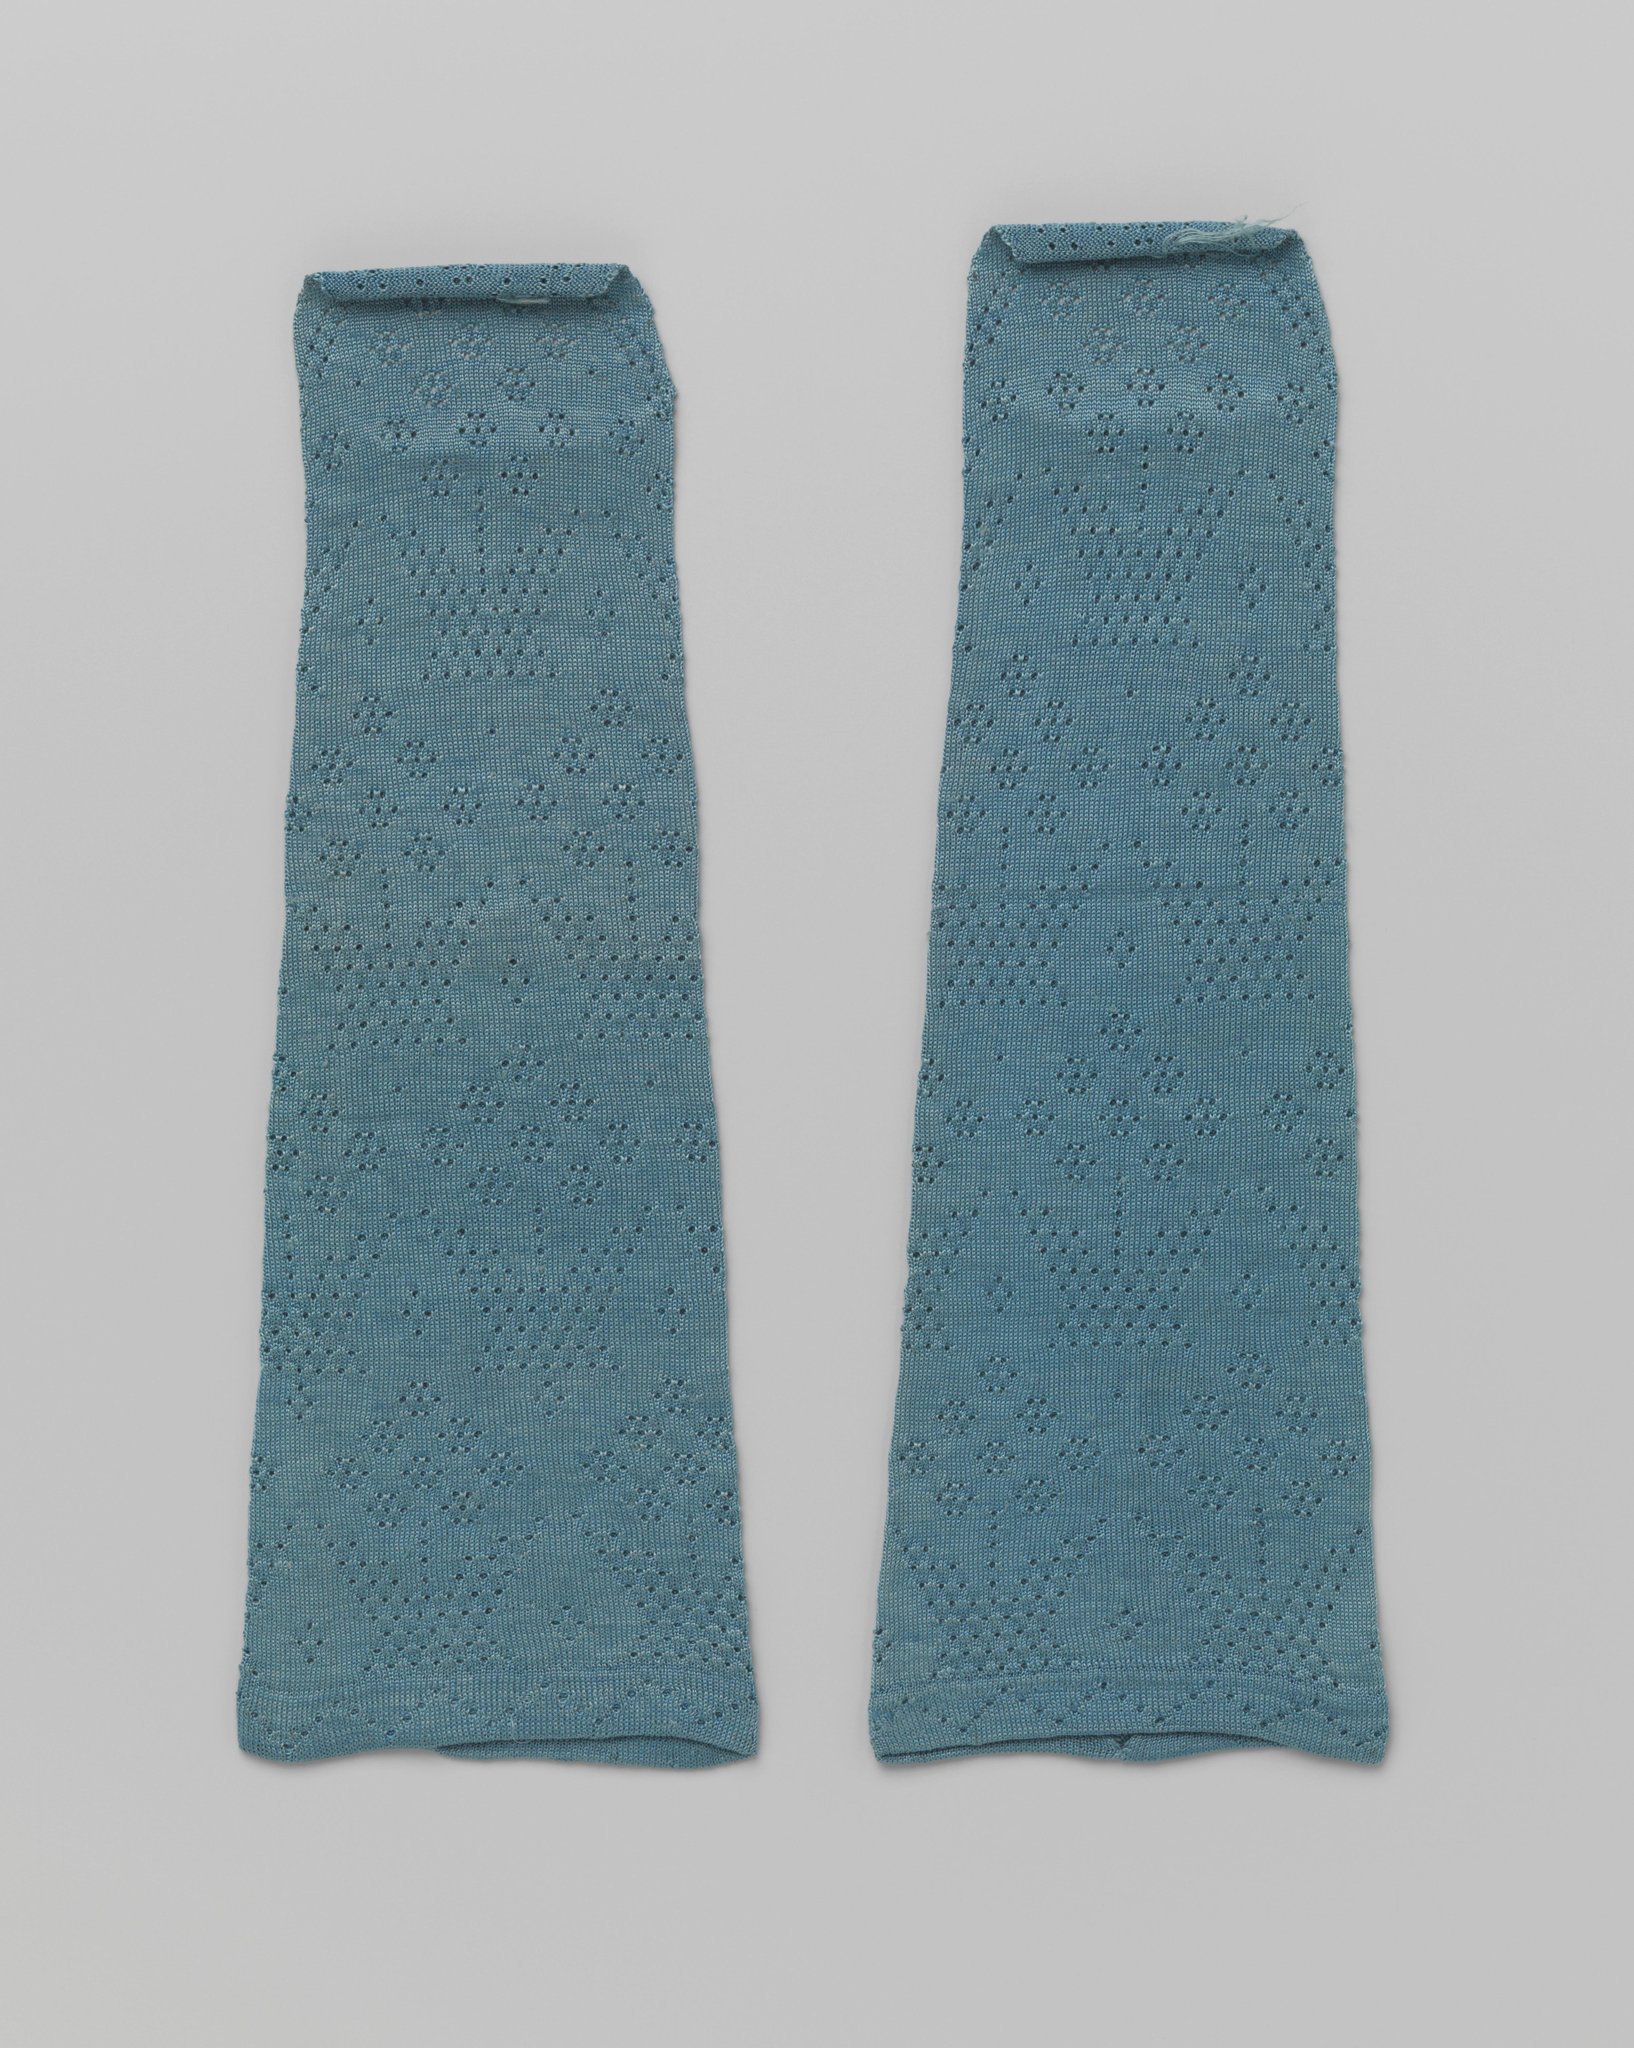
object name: clothing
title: Mitaine van blauwe zijde, open breiwerk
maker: Anonymous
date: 1750-1780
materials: silk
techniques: embroidery, knitting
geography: zaanstreek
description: Paar mitaines van open gebreide blauwe zijde. Model: Vingerloos. Met één naad. Afgeronde, bij het breien in de vorm afgekante, punt die over de handrug valt.Versiering: Grote, à-jour gebreide bloemenmanden, in verspringende rijen boven elkaar. Noord-Holland, de zaanstreek. Toestand: Gaaf van kleur.